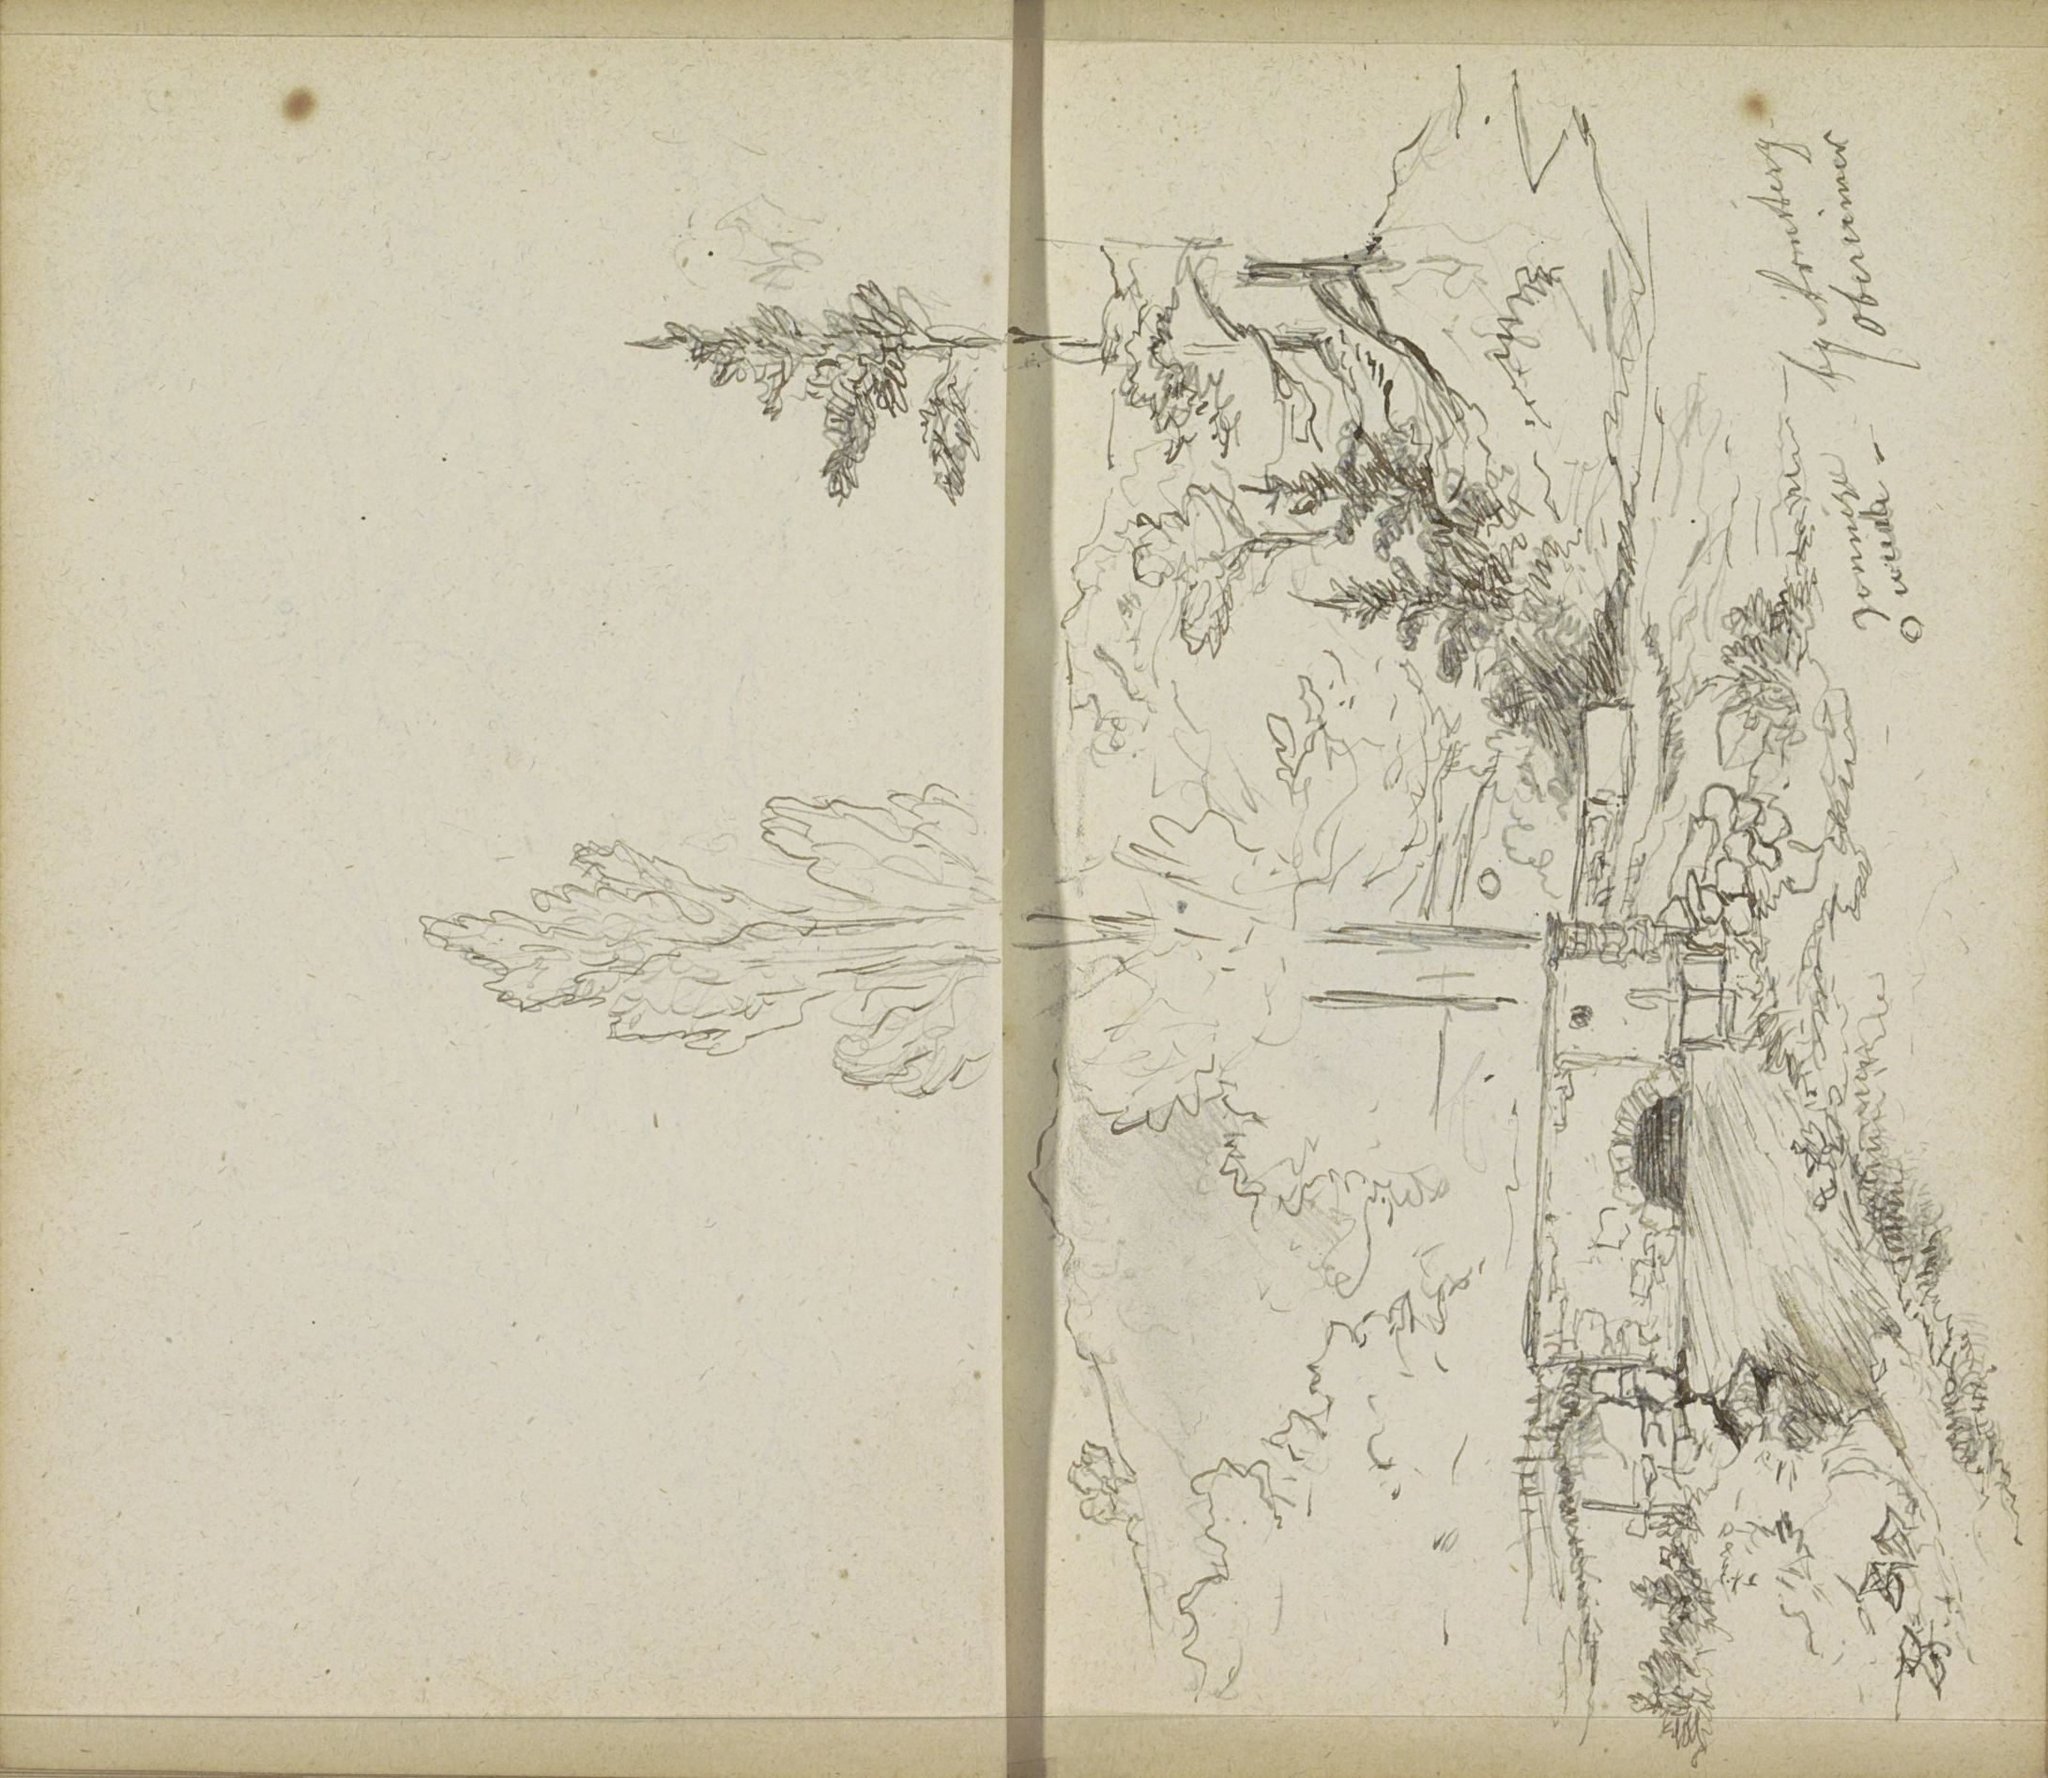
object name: sketchbook leaf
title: Stenen brug bij Obereimer in Arnsberg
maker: johannes tavenraat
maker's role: draughtsman, painter, print maker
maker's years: 1809-1881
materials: ink, paper, pencil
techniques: pen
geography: arnsberg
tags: landscapes, river, bridge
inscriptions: annotation: ‘bij Arnsberg/ obereimer’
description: Blad 27 verso en 28 recto uit een schetsboek met 88 bladen.